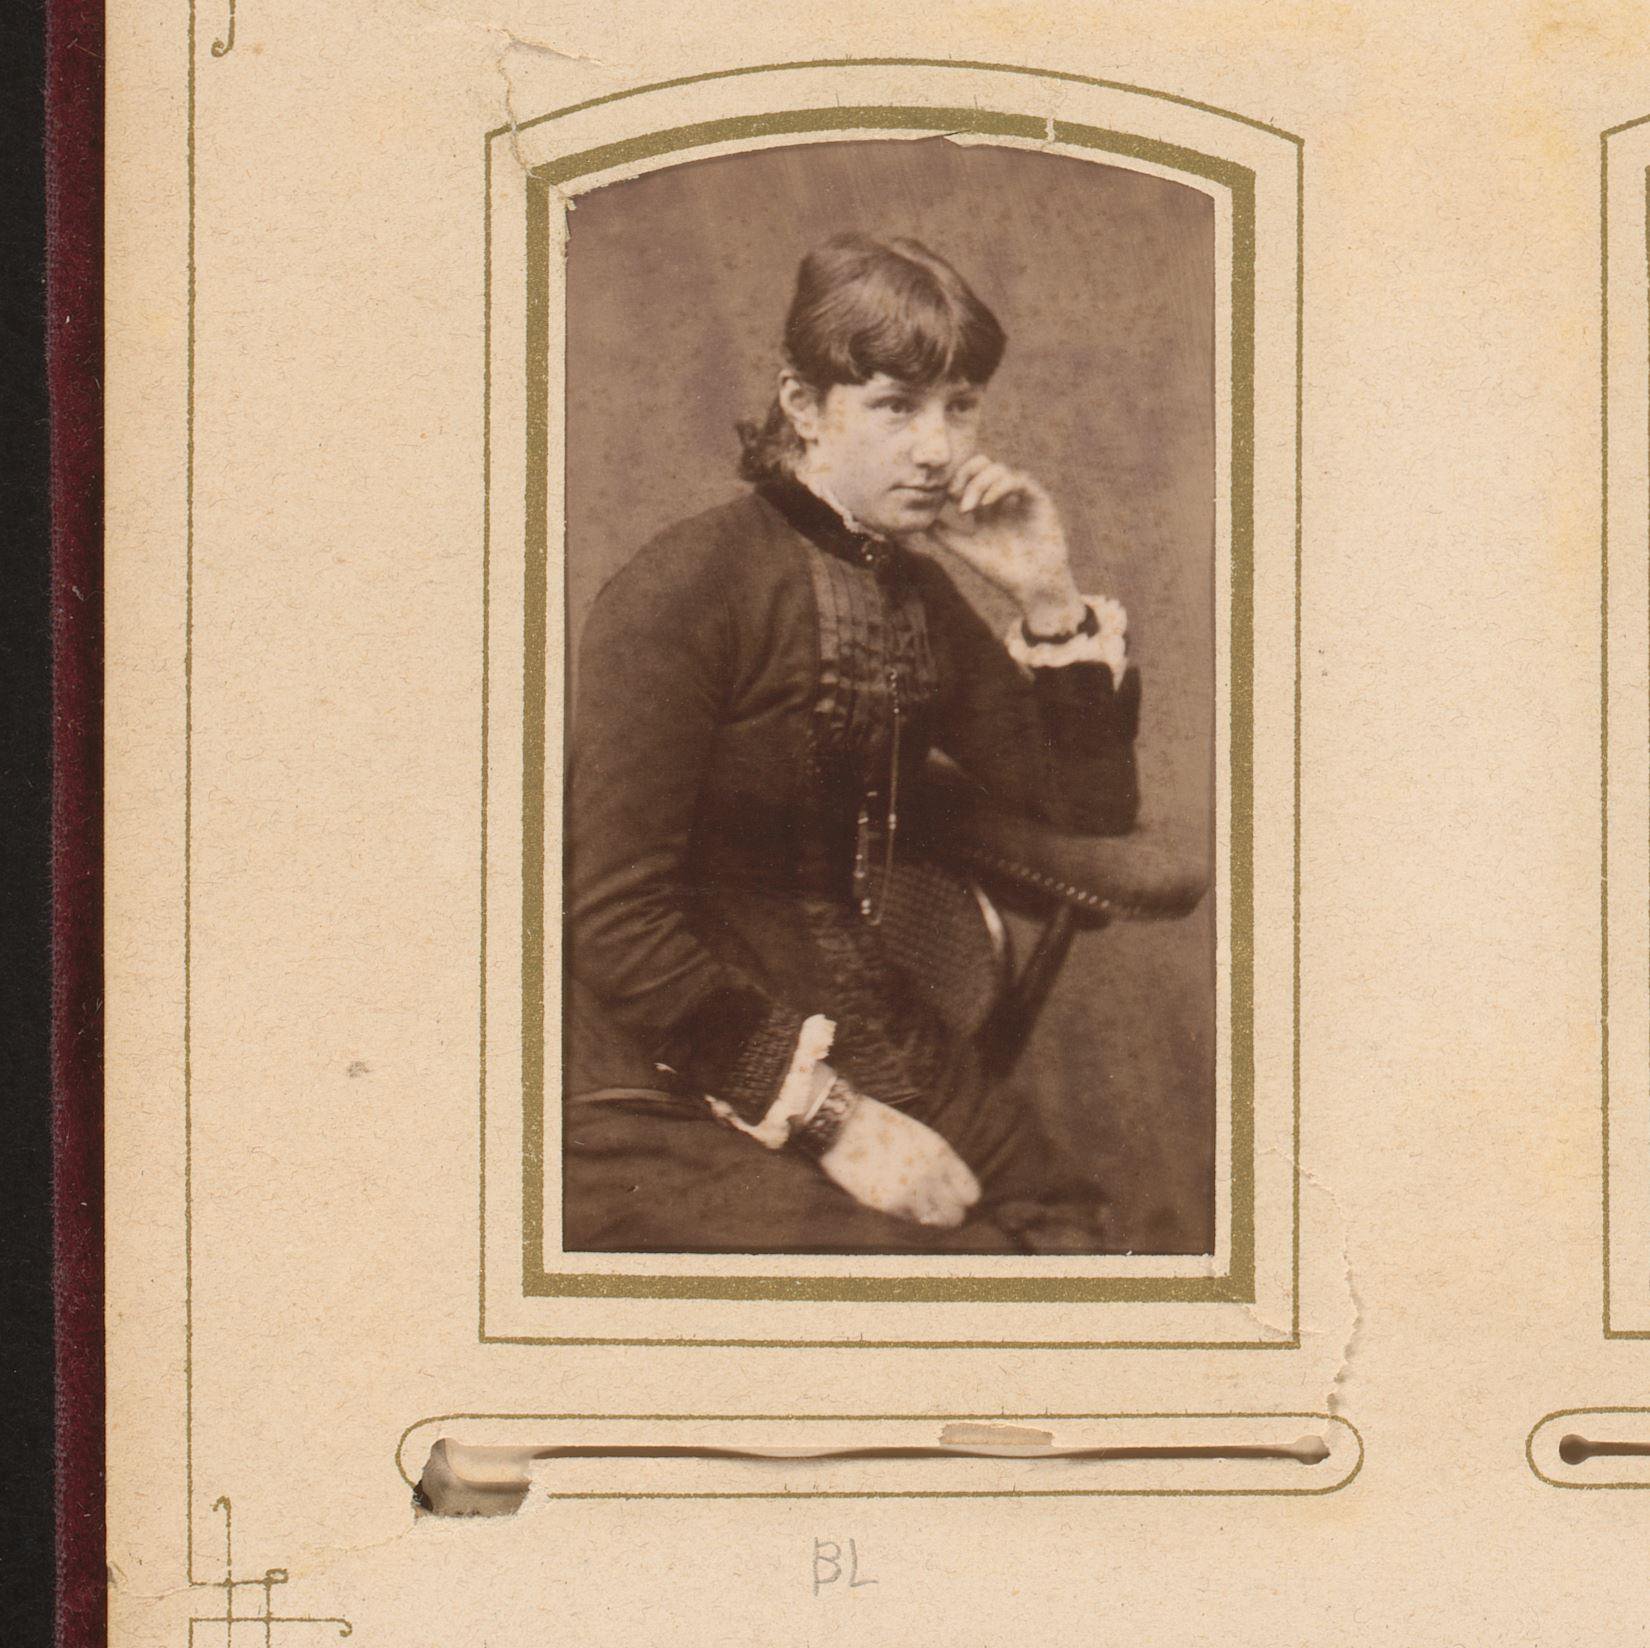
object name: album leaf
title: Portret van een zittend meisje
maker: Anonymous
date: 1870-1900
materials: cardboard, photographic support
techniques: albumen print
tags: sitting figure - aa - female human figure, historical persons - bb - woman, girl (child between toddler and youth)